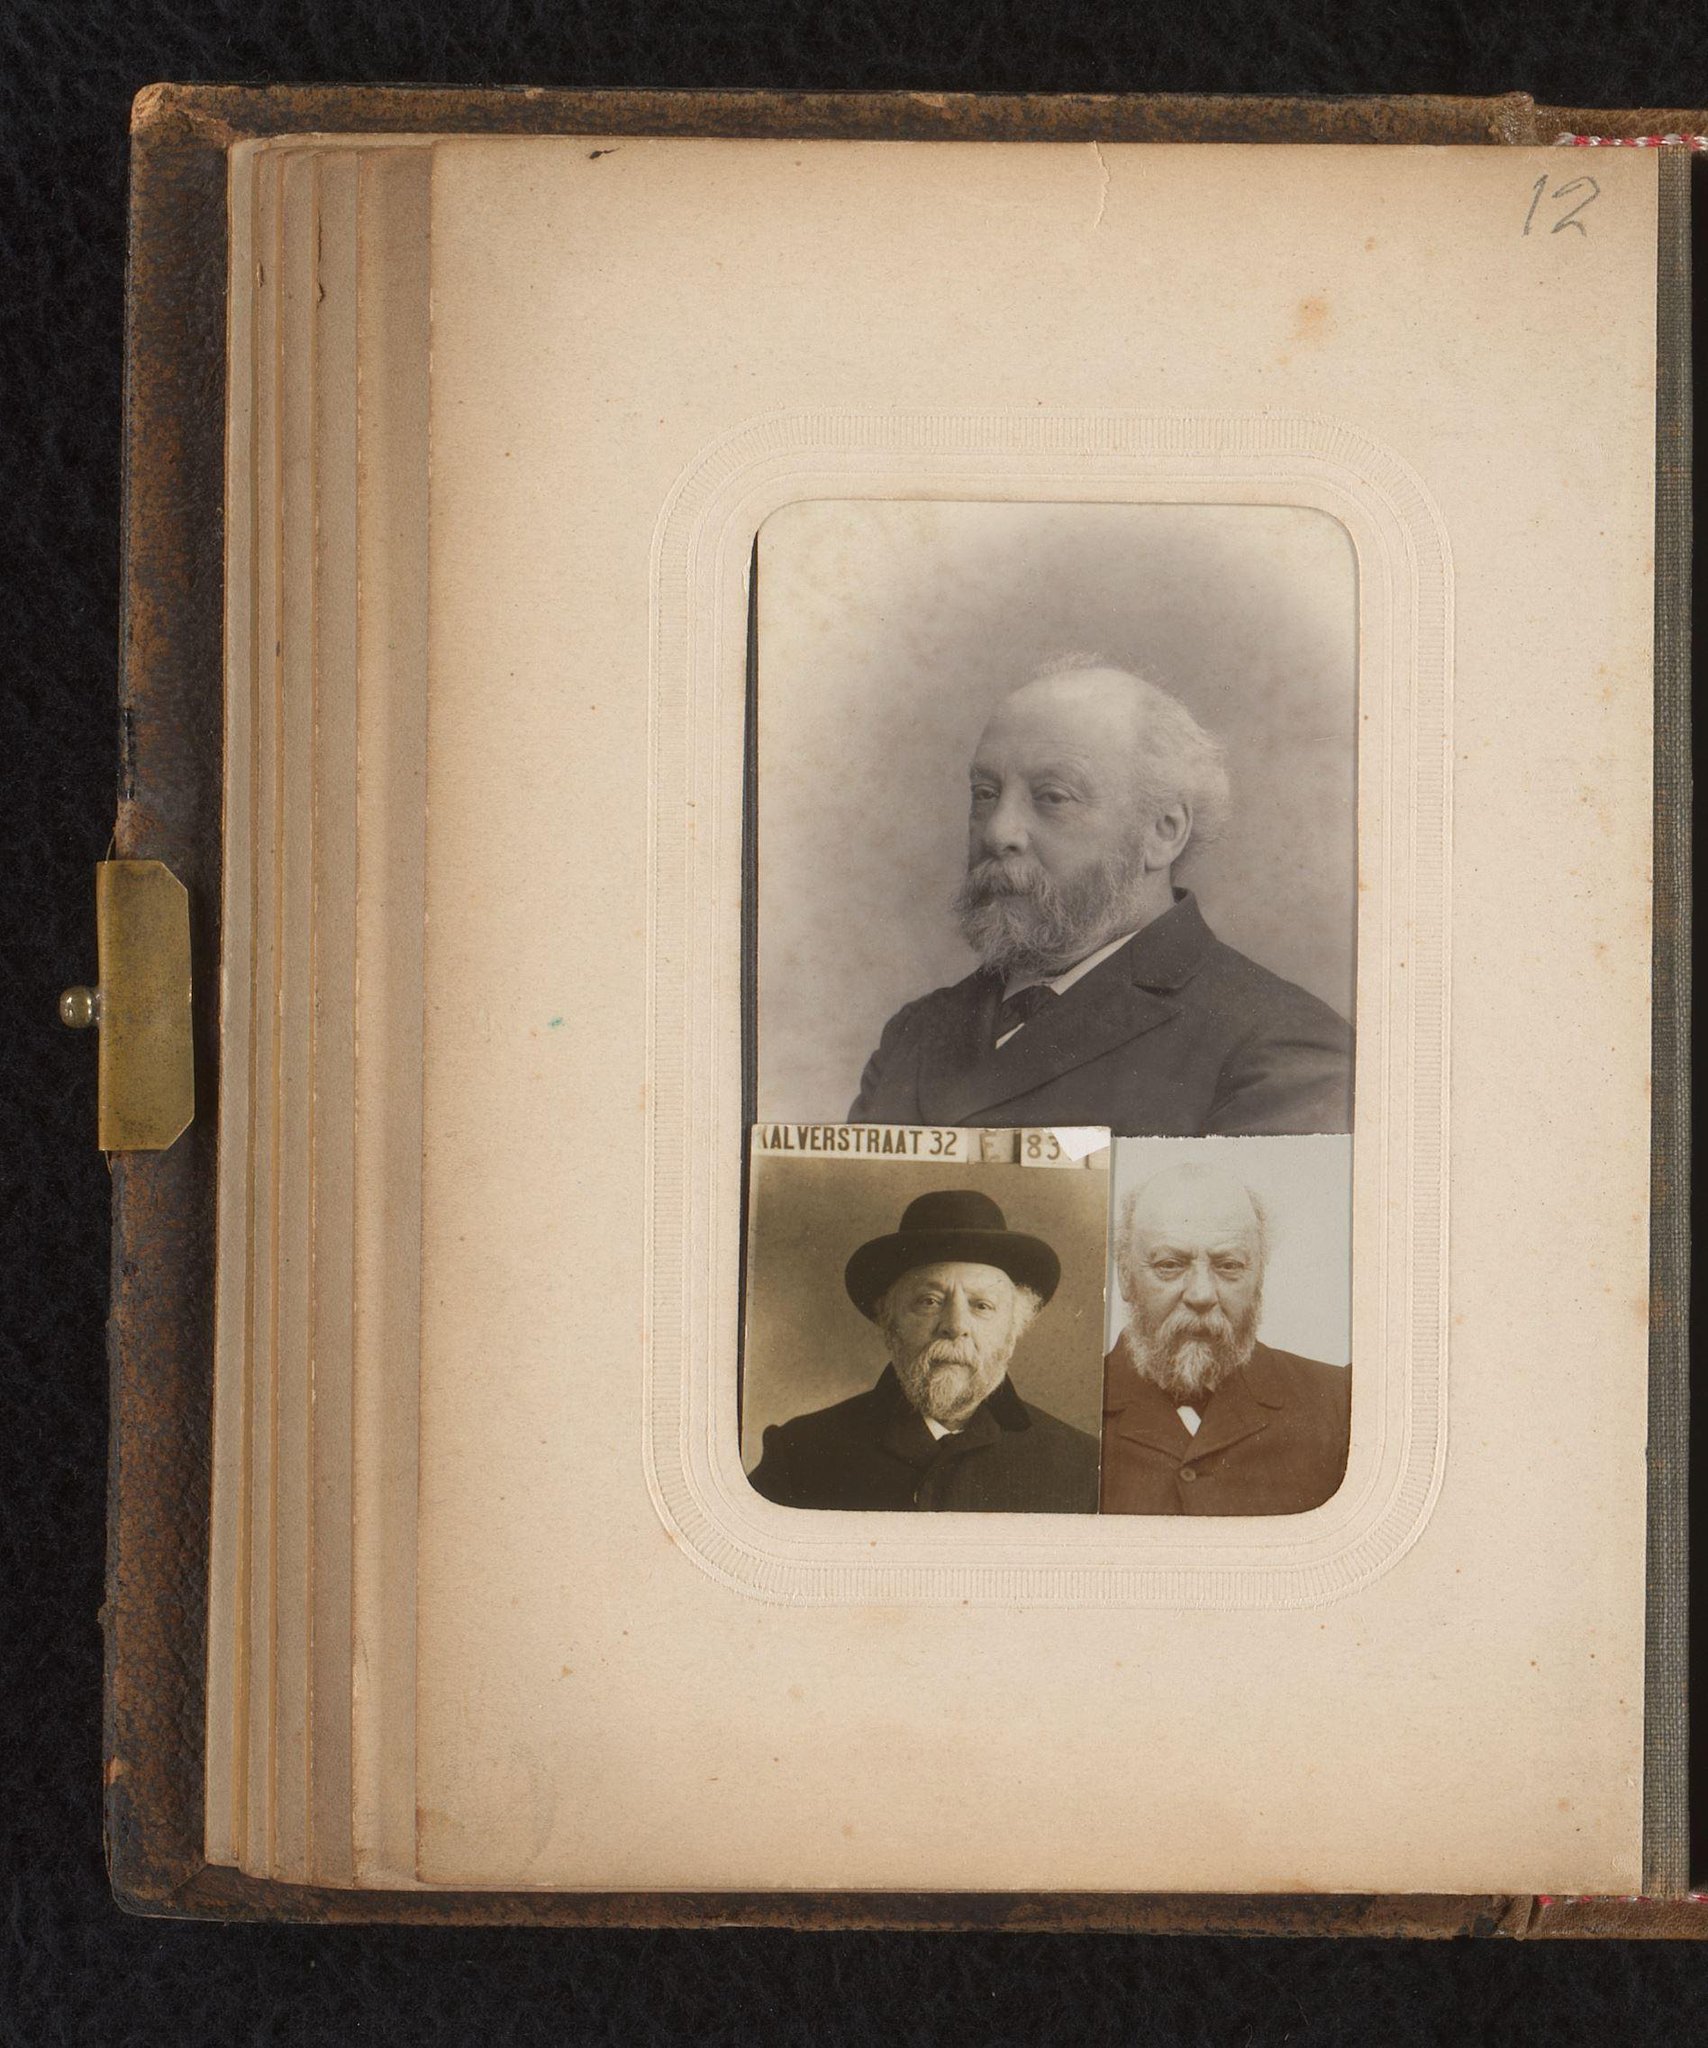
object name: carte de visite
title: Drie portretten van Petrus Hermanus Bon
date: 1904-1917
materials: paper, cardboard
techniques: gelatin silver print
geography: amsterdam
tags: amsterdam, historical persons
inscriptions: inscription: ‘Opa Bon’, inscription: ‘Opa./ Petrus/ Hermanus/ Bon’, inscription: ‘'s Gravenhage 1904 (...) Amsterdam - Vlaardingen’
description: Deze foto's maken deel uit van een album.